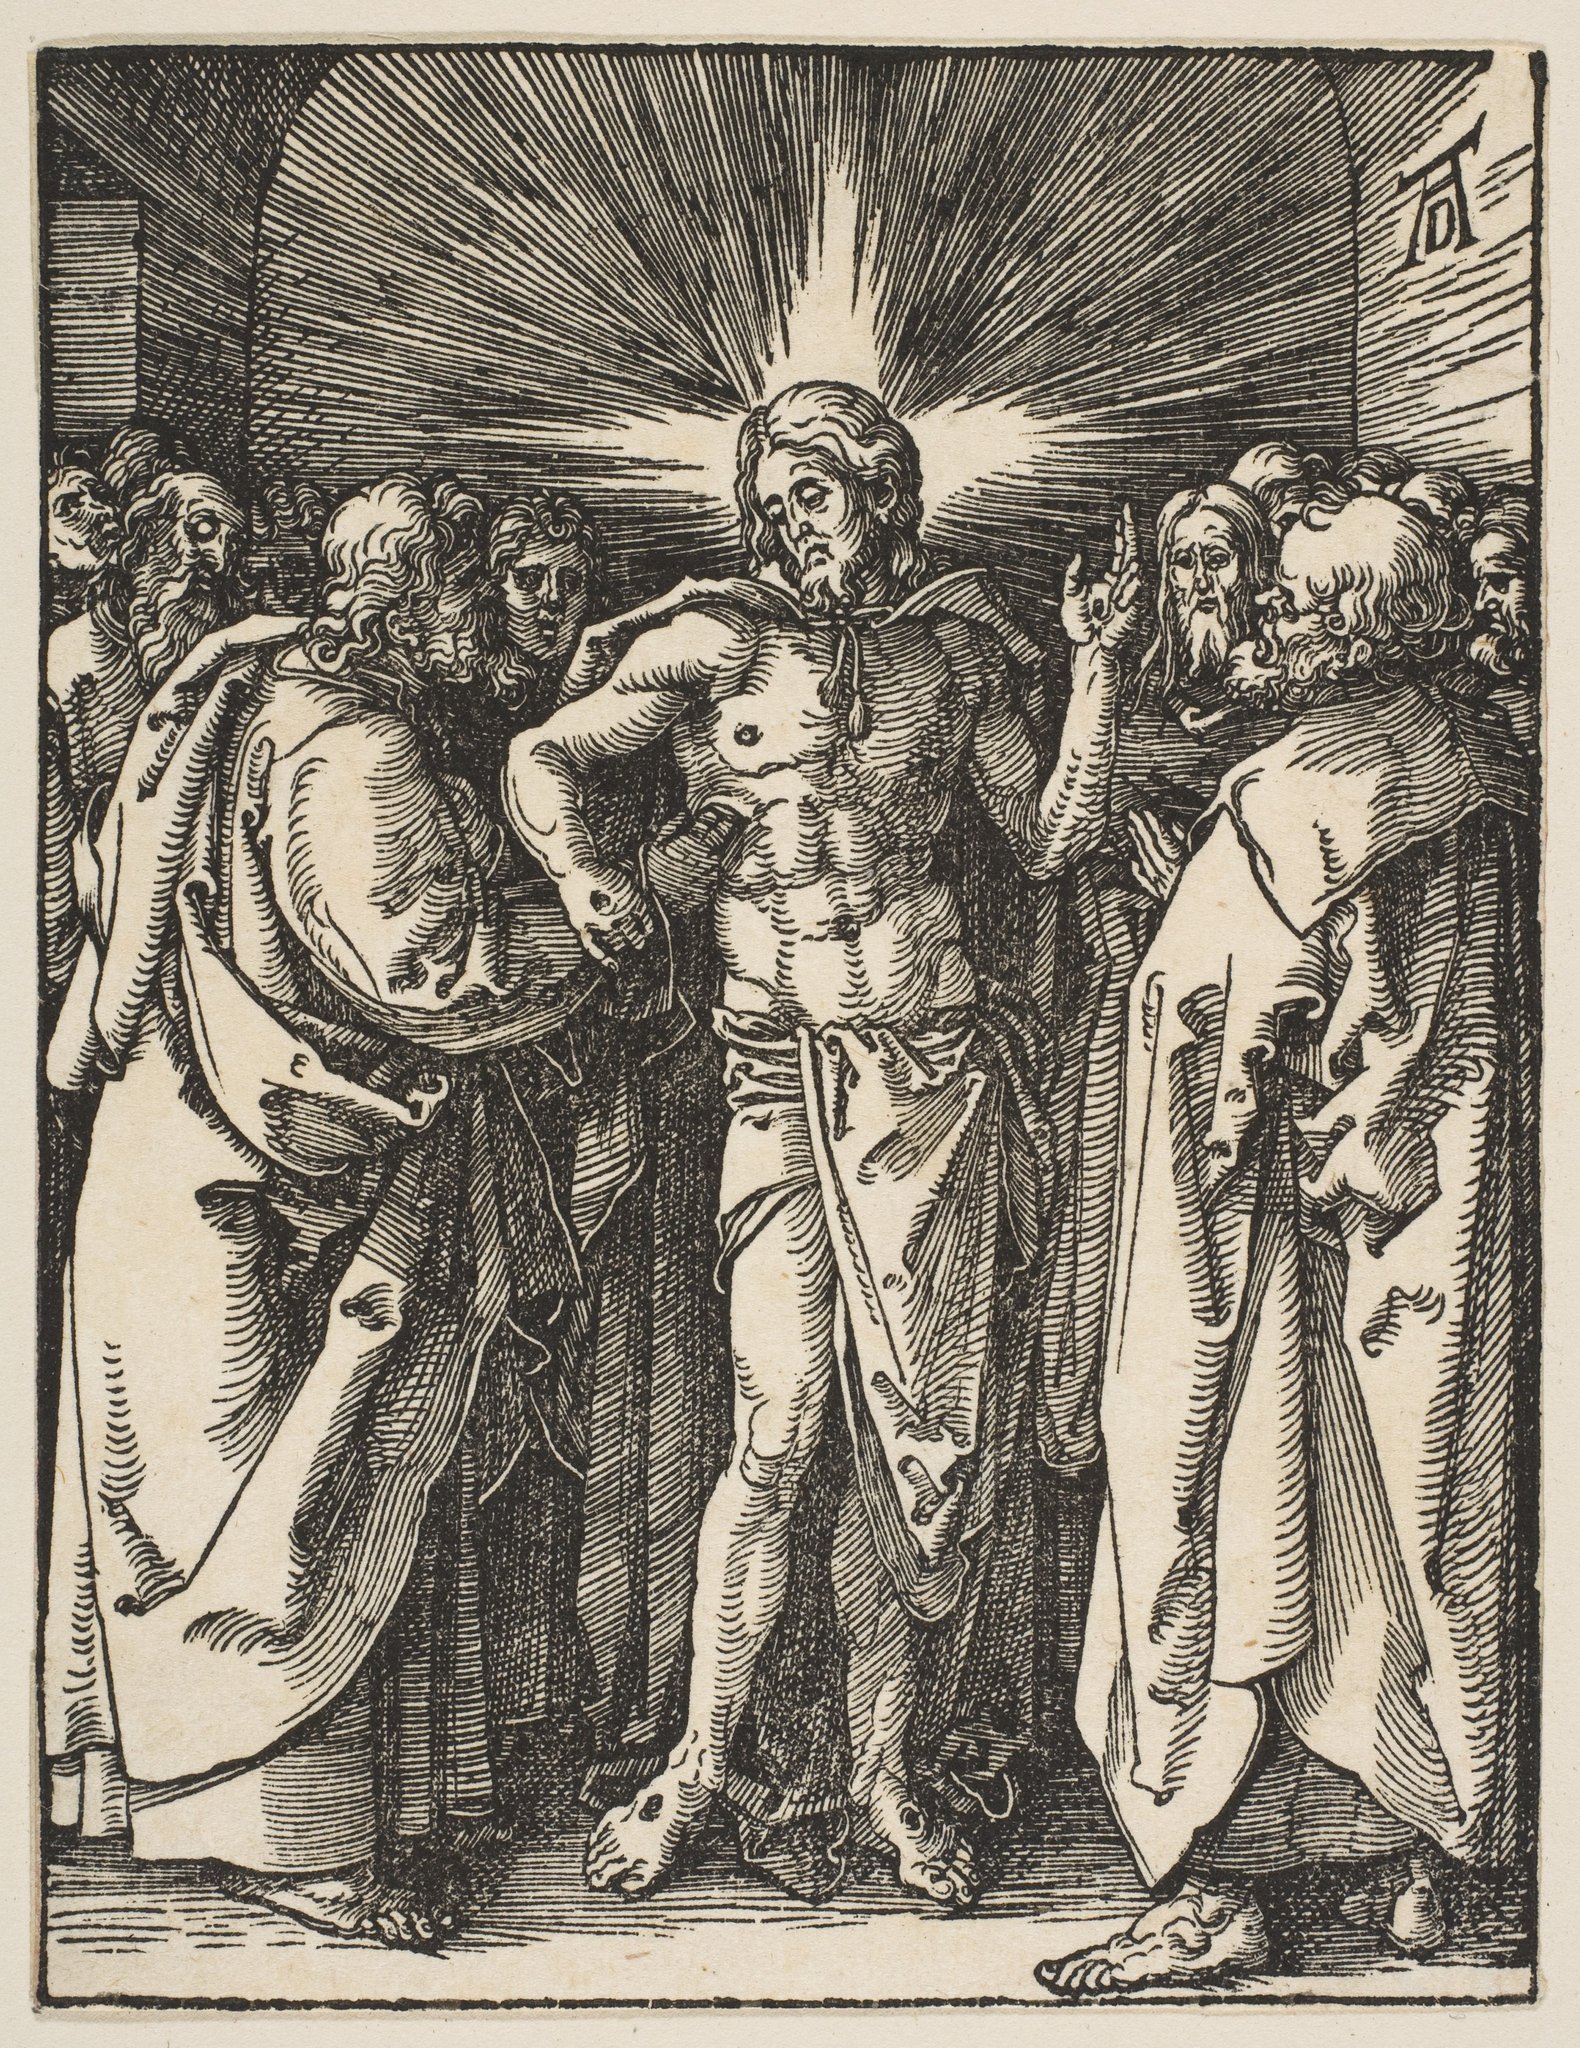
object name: print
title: The Doubting Thomas, from "The Small Passion"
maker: albrecht dürer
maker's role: artist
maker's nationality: german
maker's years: 1471-1528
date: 1510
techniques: woodcut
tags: men,apostles,christ